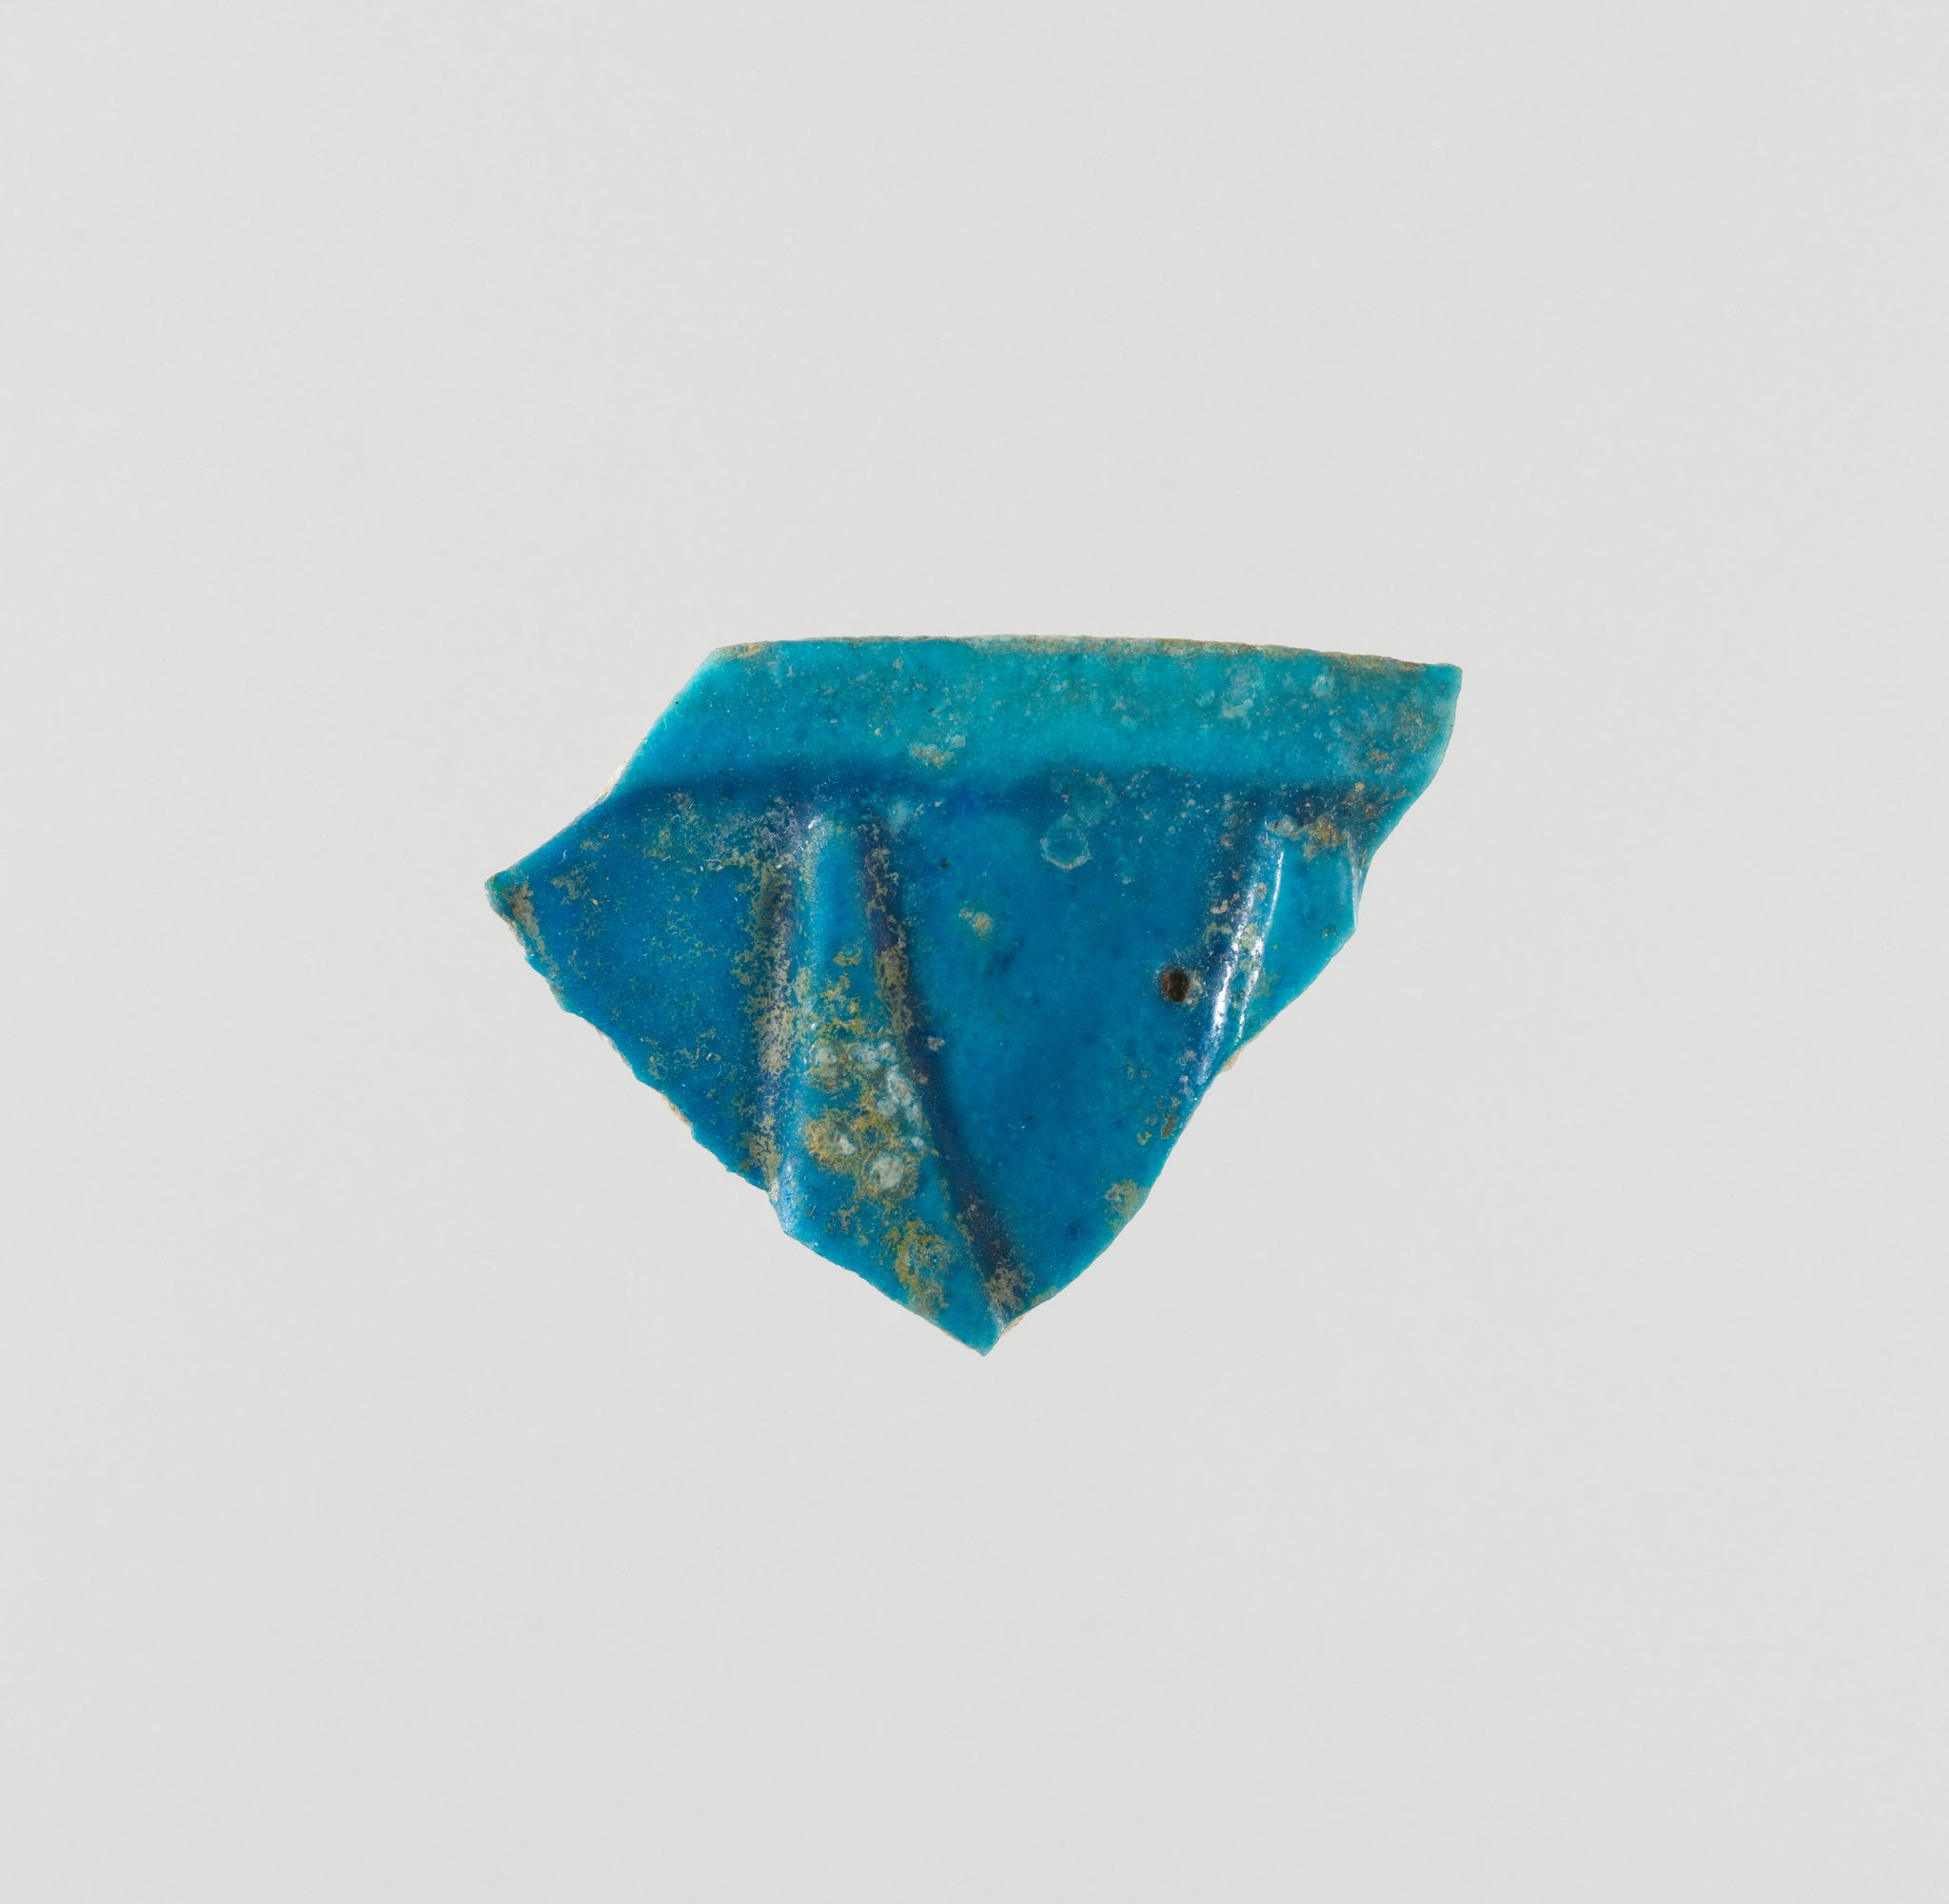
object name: chalice, cup, lotiform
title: Rim Fragment of a Lotiform Chalice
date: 1070-664 BCE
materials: faience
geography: egypt